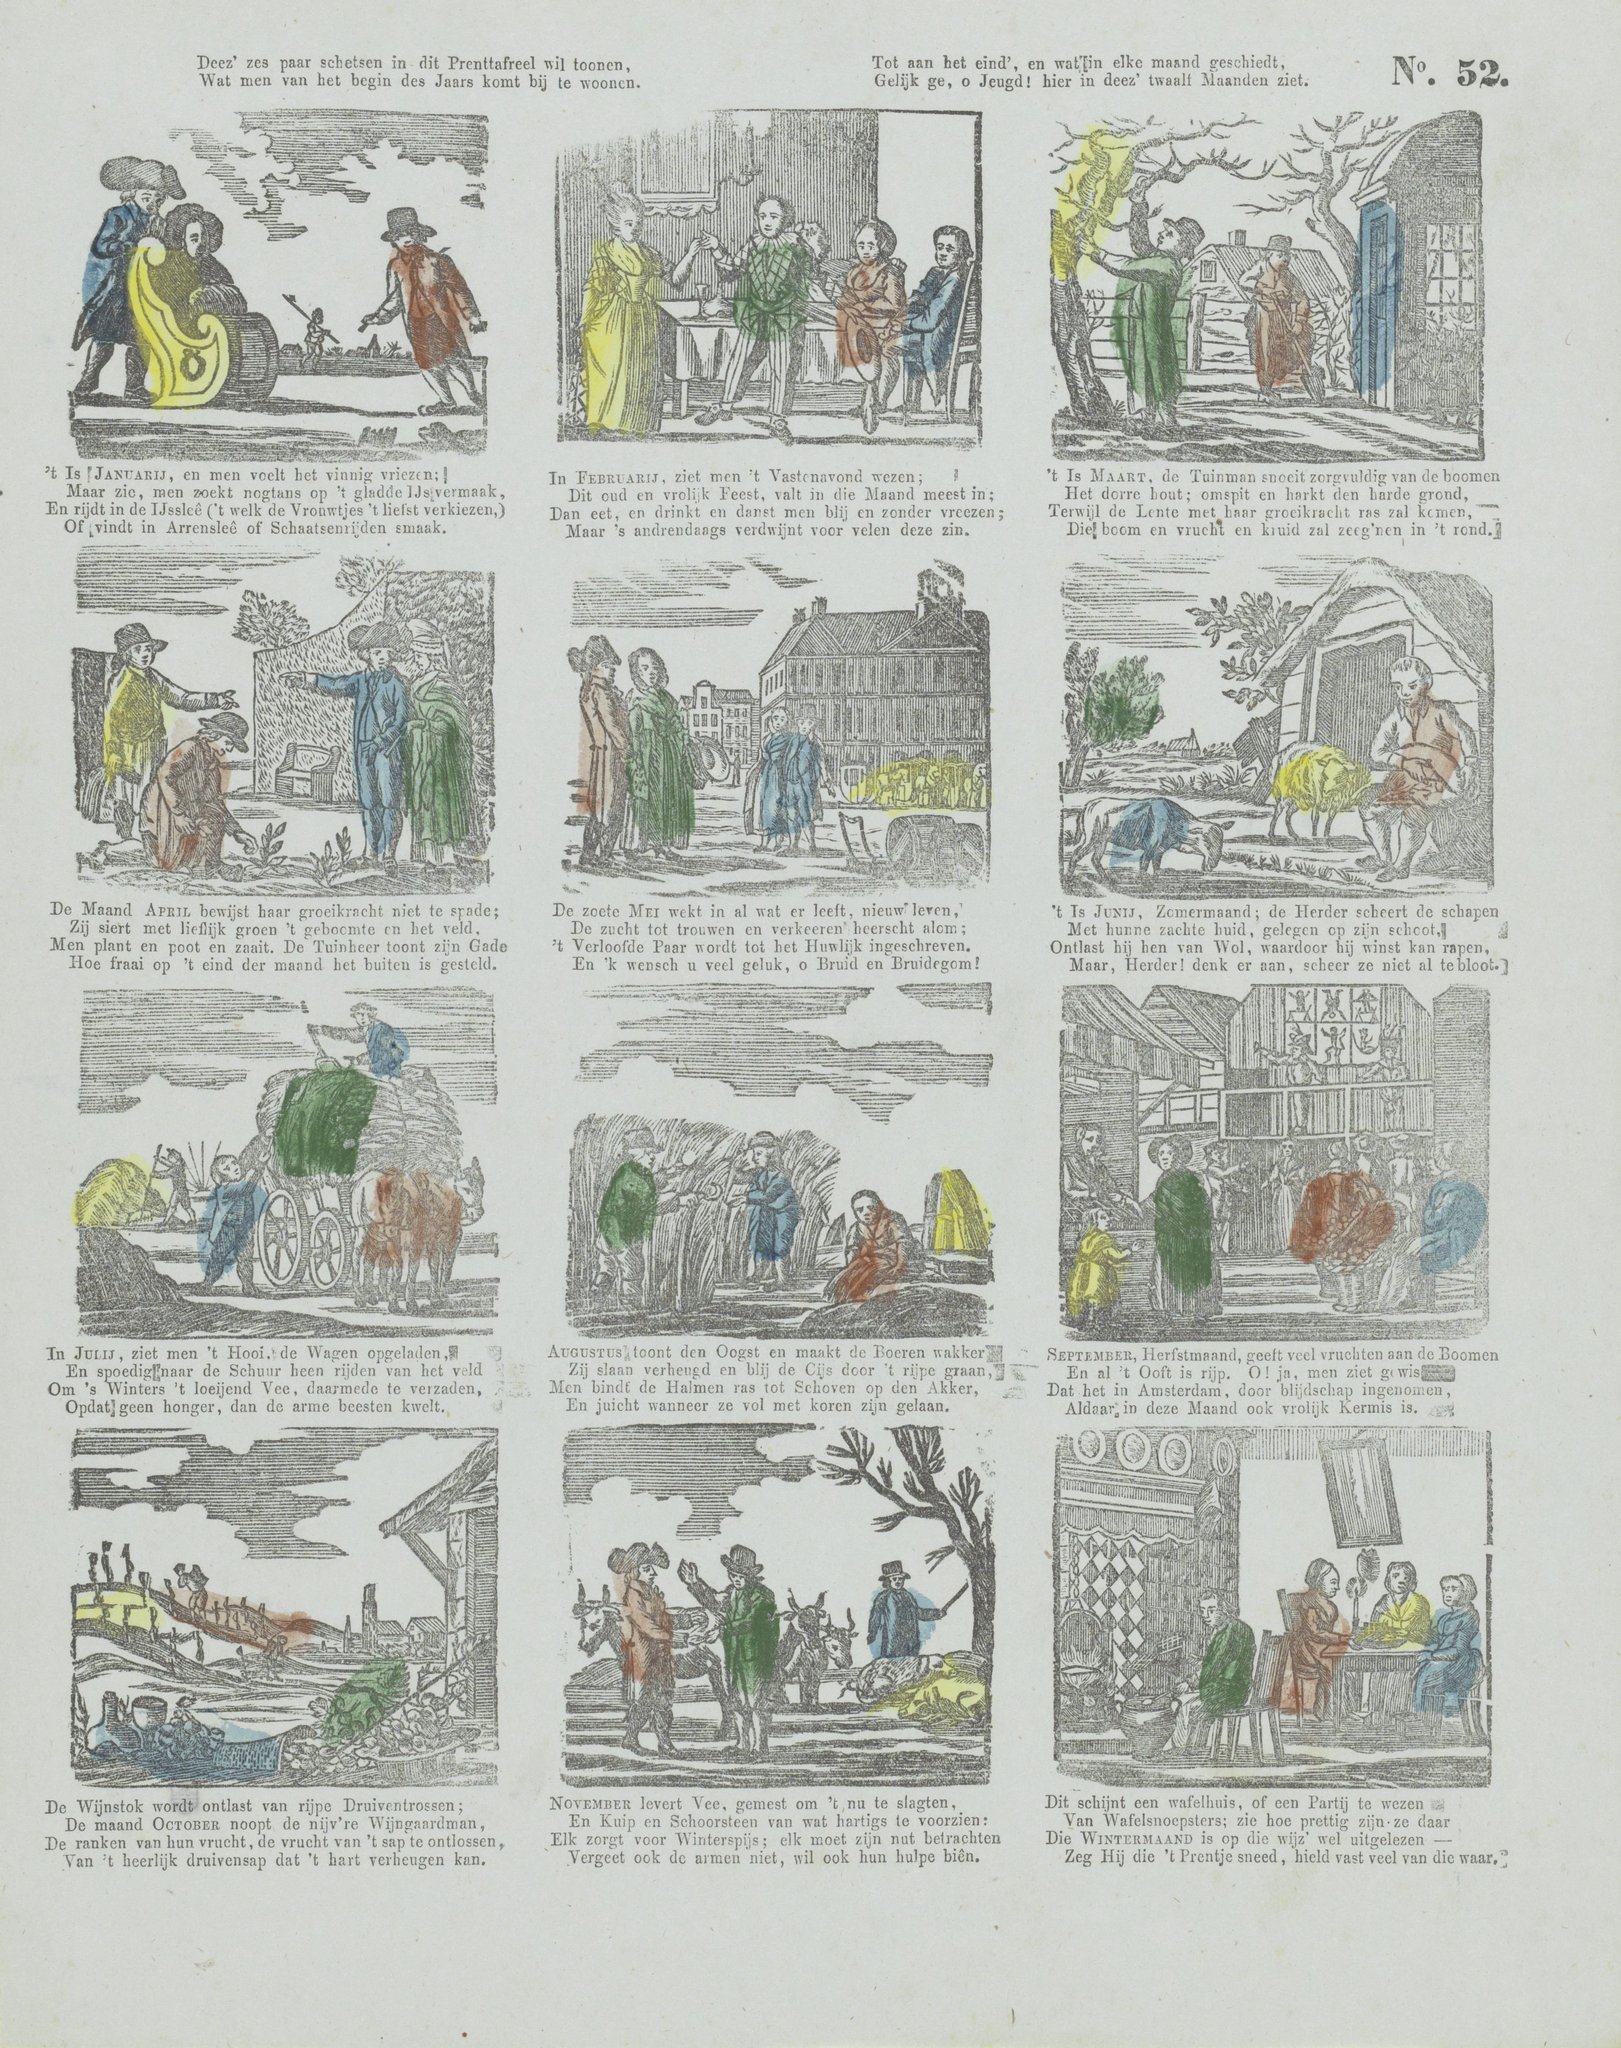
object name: print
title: Deez' zes paar schetsen in dit prenttafreel wil toonen, / Wat men van het begin des jaars komt bij te woonen, / Tot aan het eind', en wat in elke maand geschiedt, / Gelijk ge, o jeugd! hier in deez' twaalf maanden ziet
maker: Anonymous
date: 1850-1870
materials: paper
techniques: colour, letterpress printing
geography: netherlands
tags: the twelve months represented by scenes showing human activities, usually in a landscape; so-called 'labours of the months'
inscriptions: collector's mark: Lugt 2760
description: Blad met 12 voorstellingen van de twaalf maanden van het jaar en bijbehorende activiteiten. Onder elke afbeelding een onderschrift. Genummerd rechtsboven: No. 52.